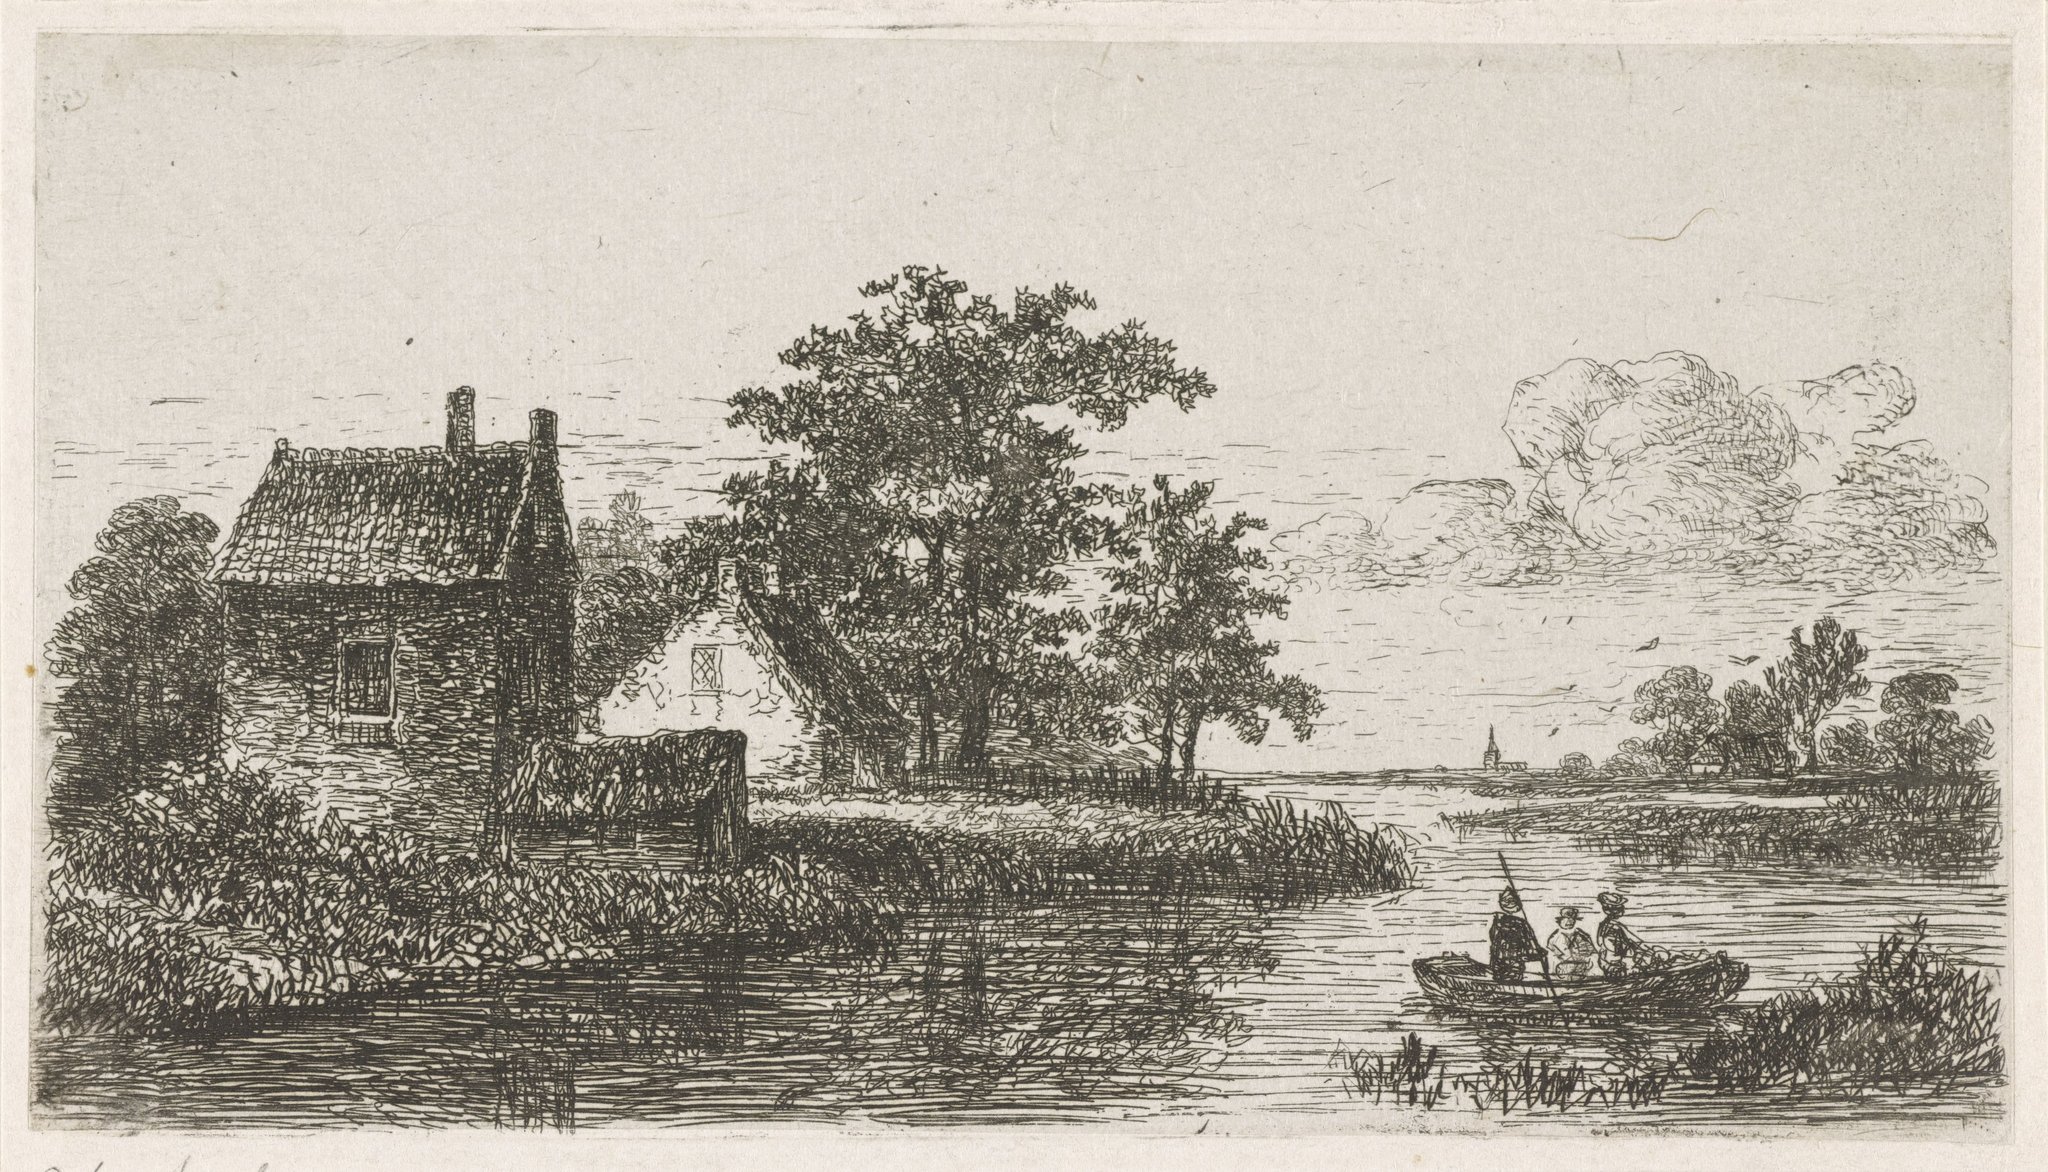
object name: print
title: Drie mannen in een boot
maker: hermanus jan hendrik van rijkelijkhuysen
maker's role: painter, print maker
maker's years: 1813-1883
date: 1823-1883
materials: paper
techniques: drypoint, etching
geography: utrecht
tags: river, church (exterior), rowing-boat, canoe, etc., farm or solitary house in landscape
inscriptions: collector's mark: Lugt 2228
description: Riviergezicht met drie mannen in een boot en aan de waterkant twee woningen. Op de achtergrond de contouren van een kerk.